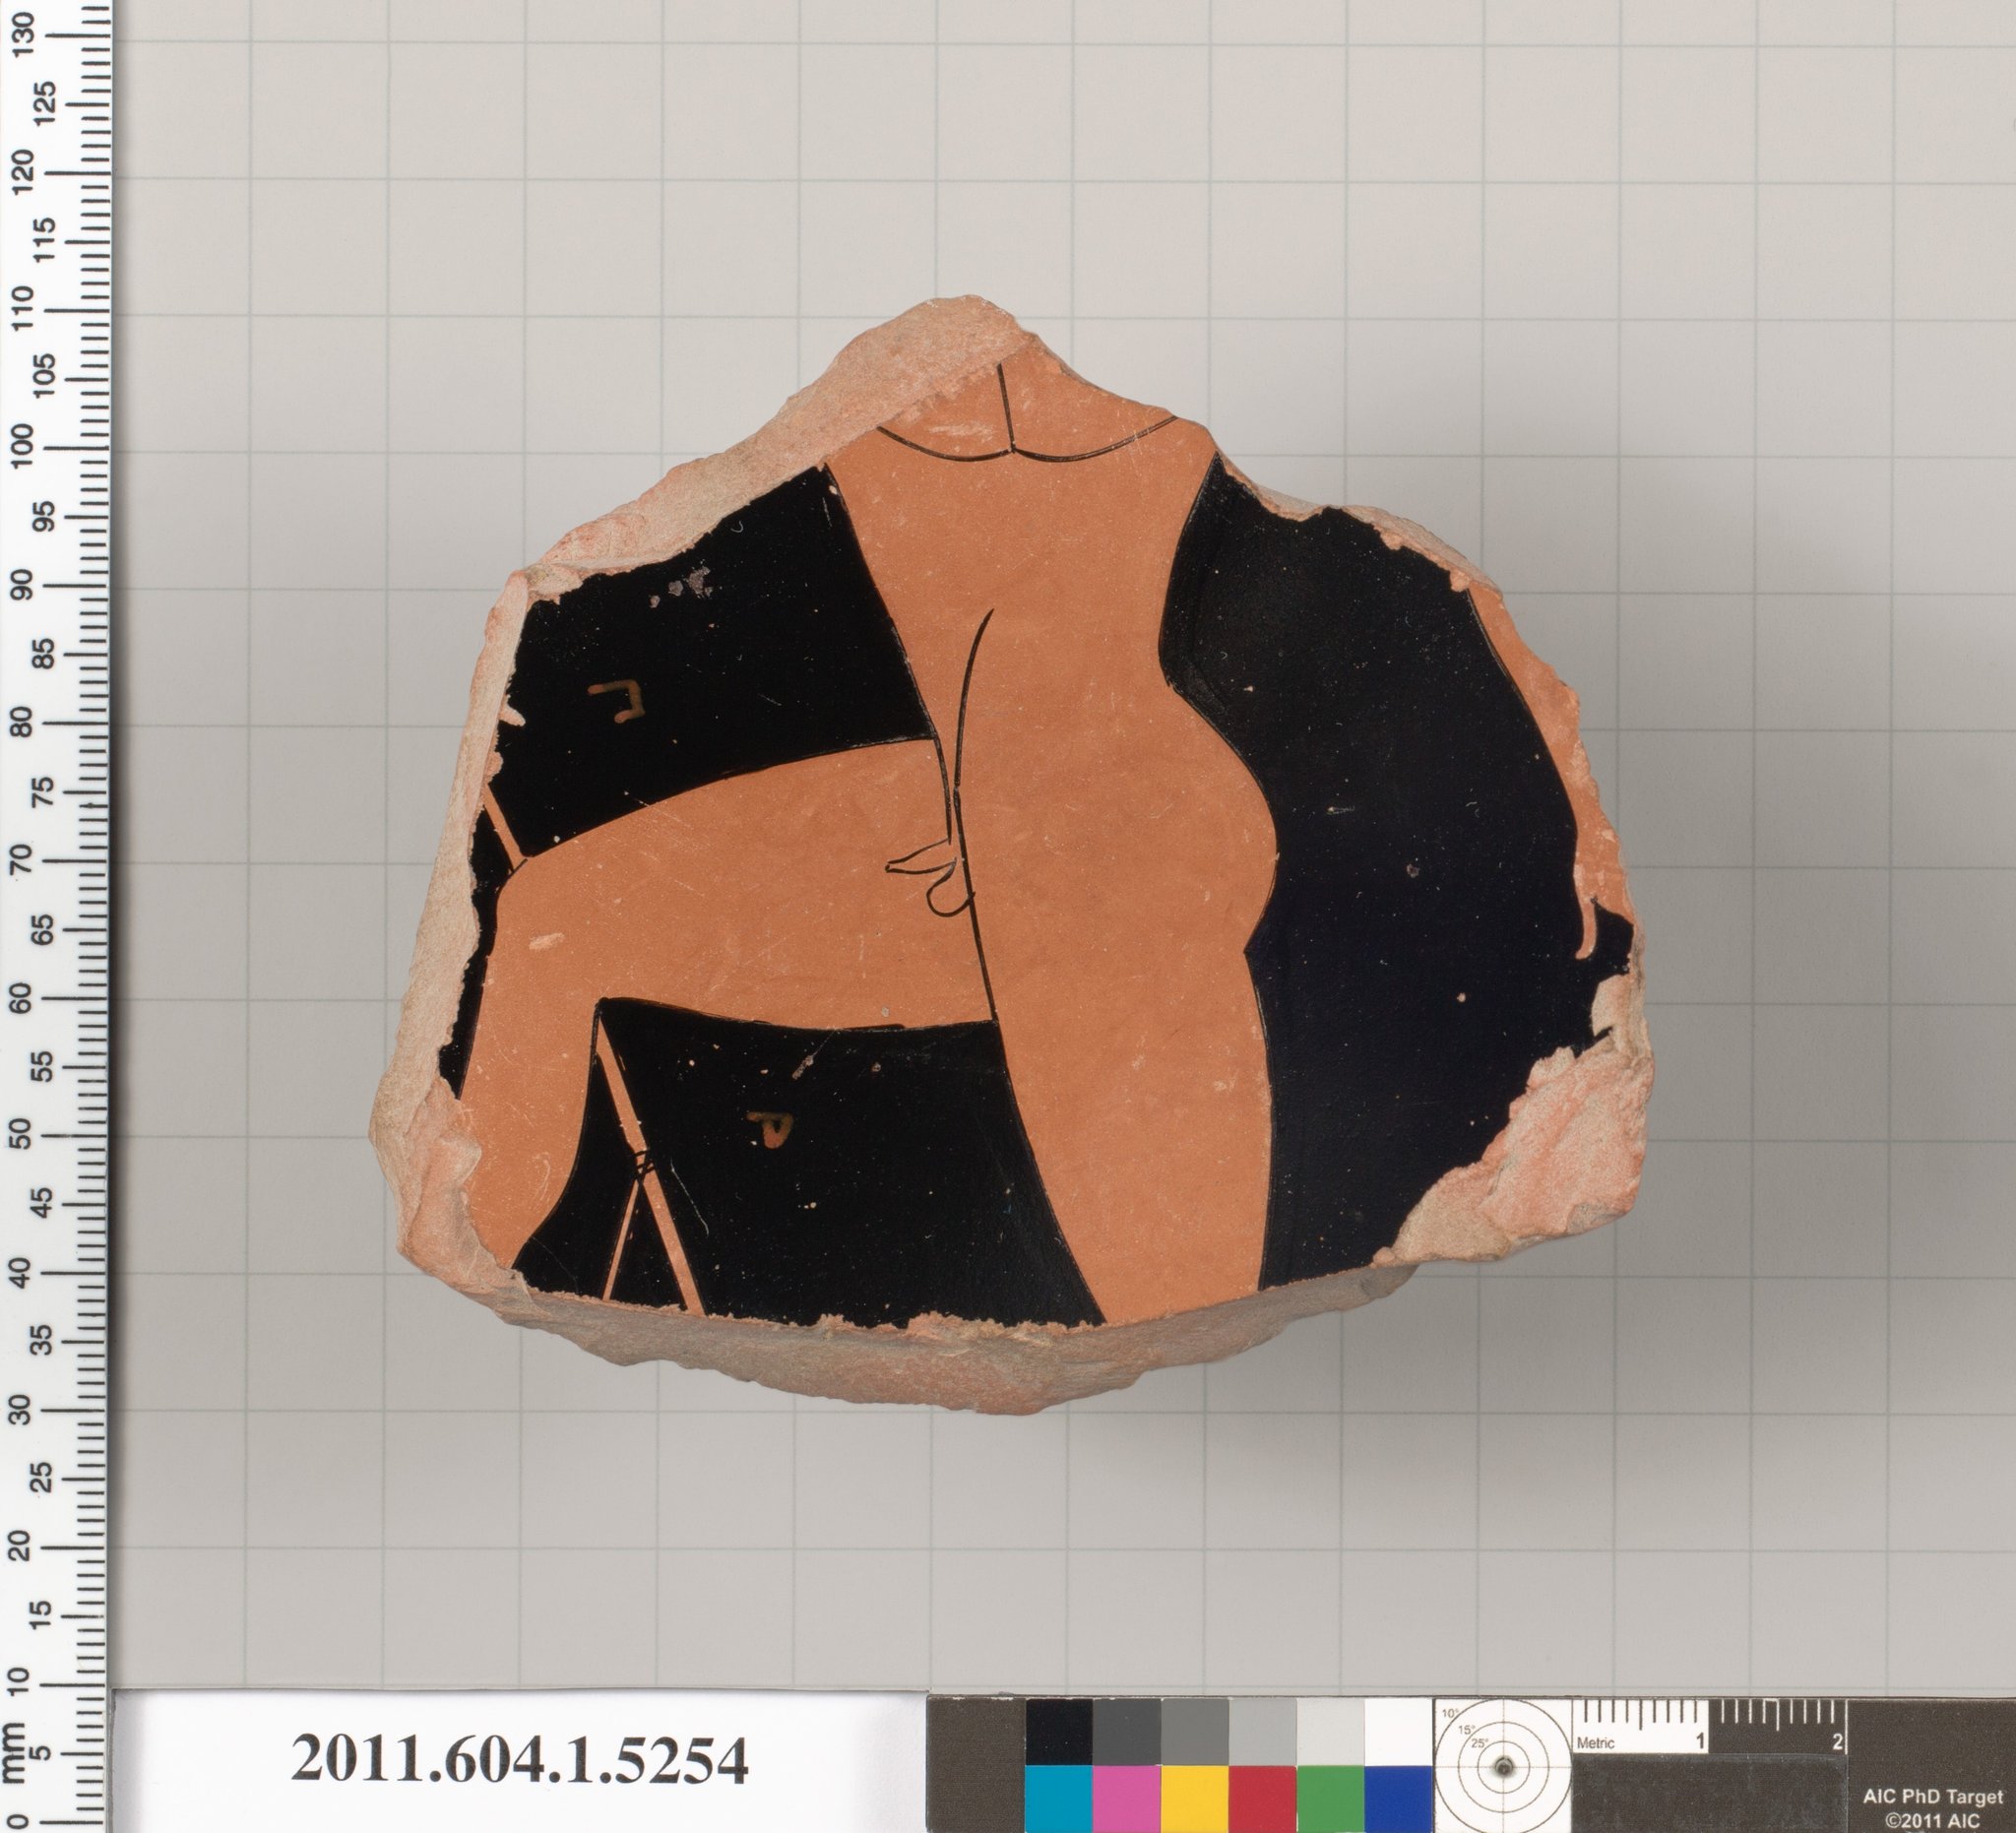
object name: kylix fragment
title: Terracotta fragment of a kylix (drinking cup)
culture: greek, attic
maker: poseidon painter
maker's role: artist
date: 510-500 BCE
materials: terracotta